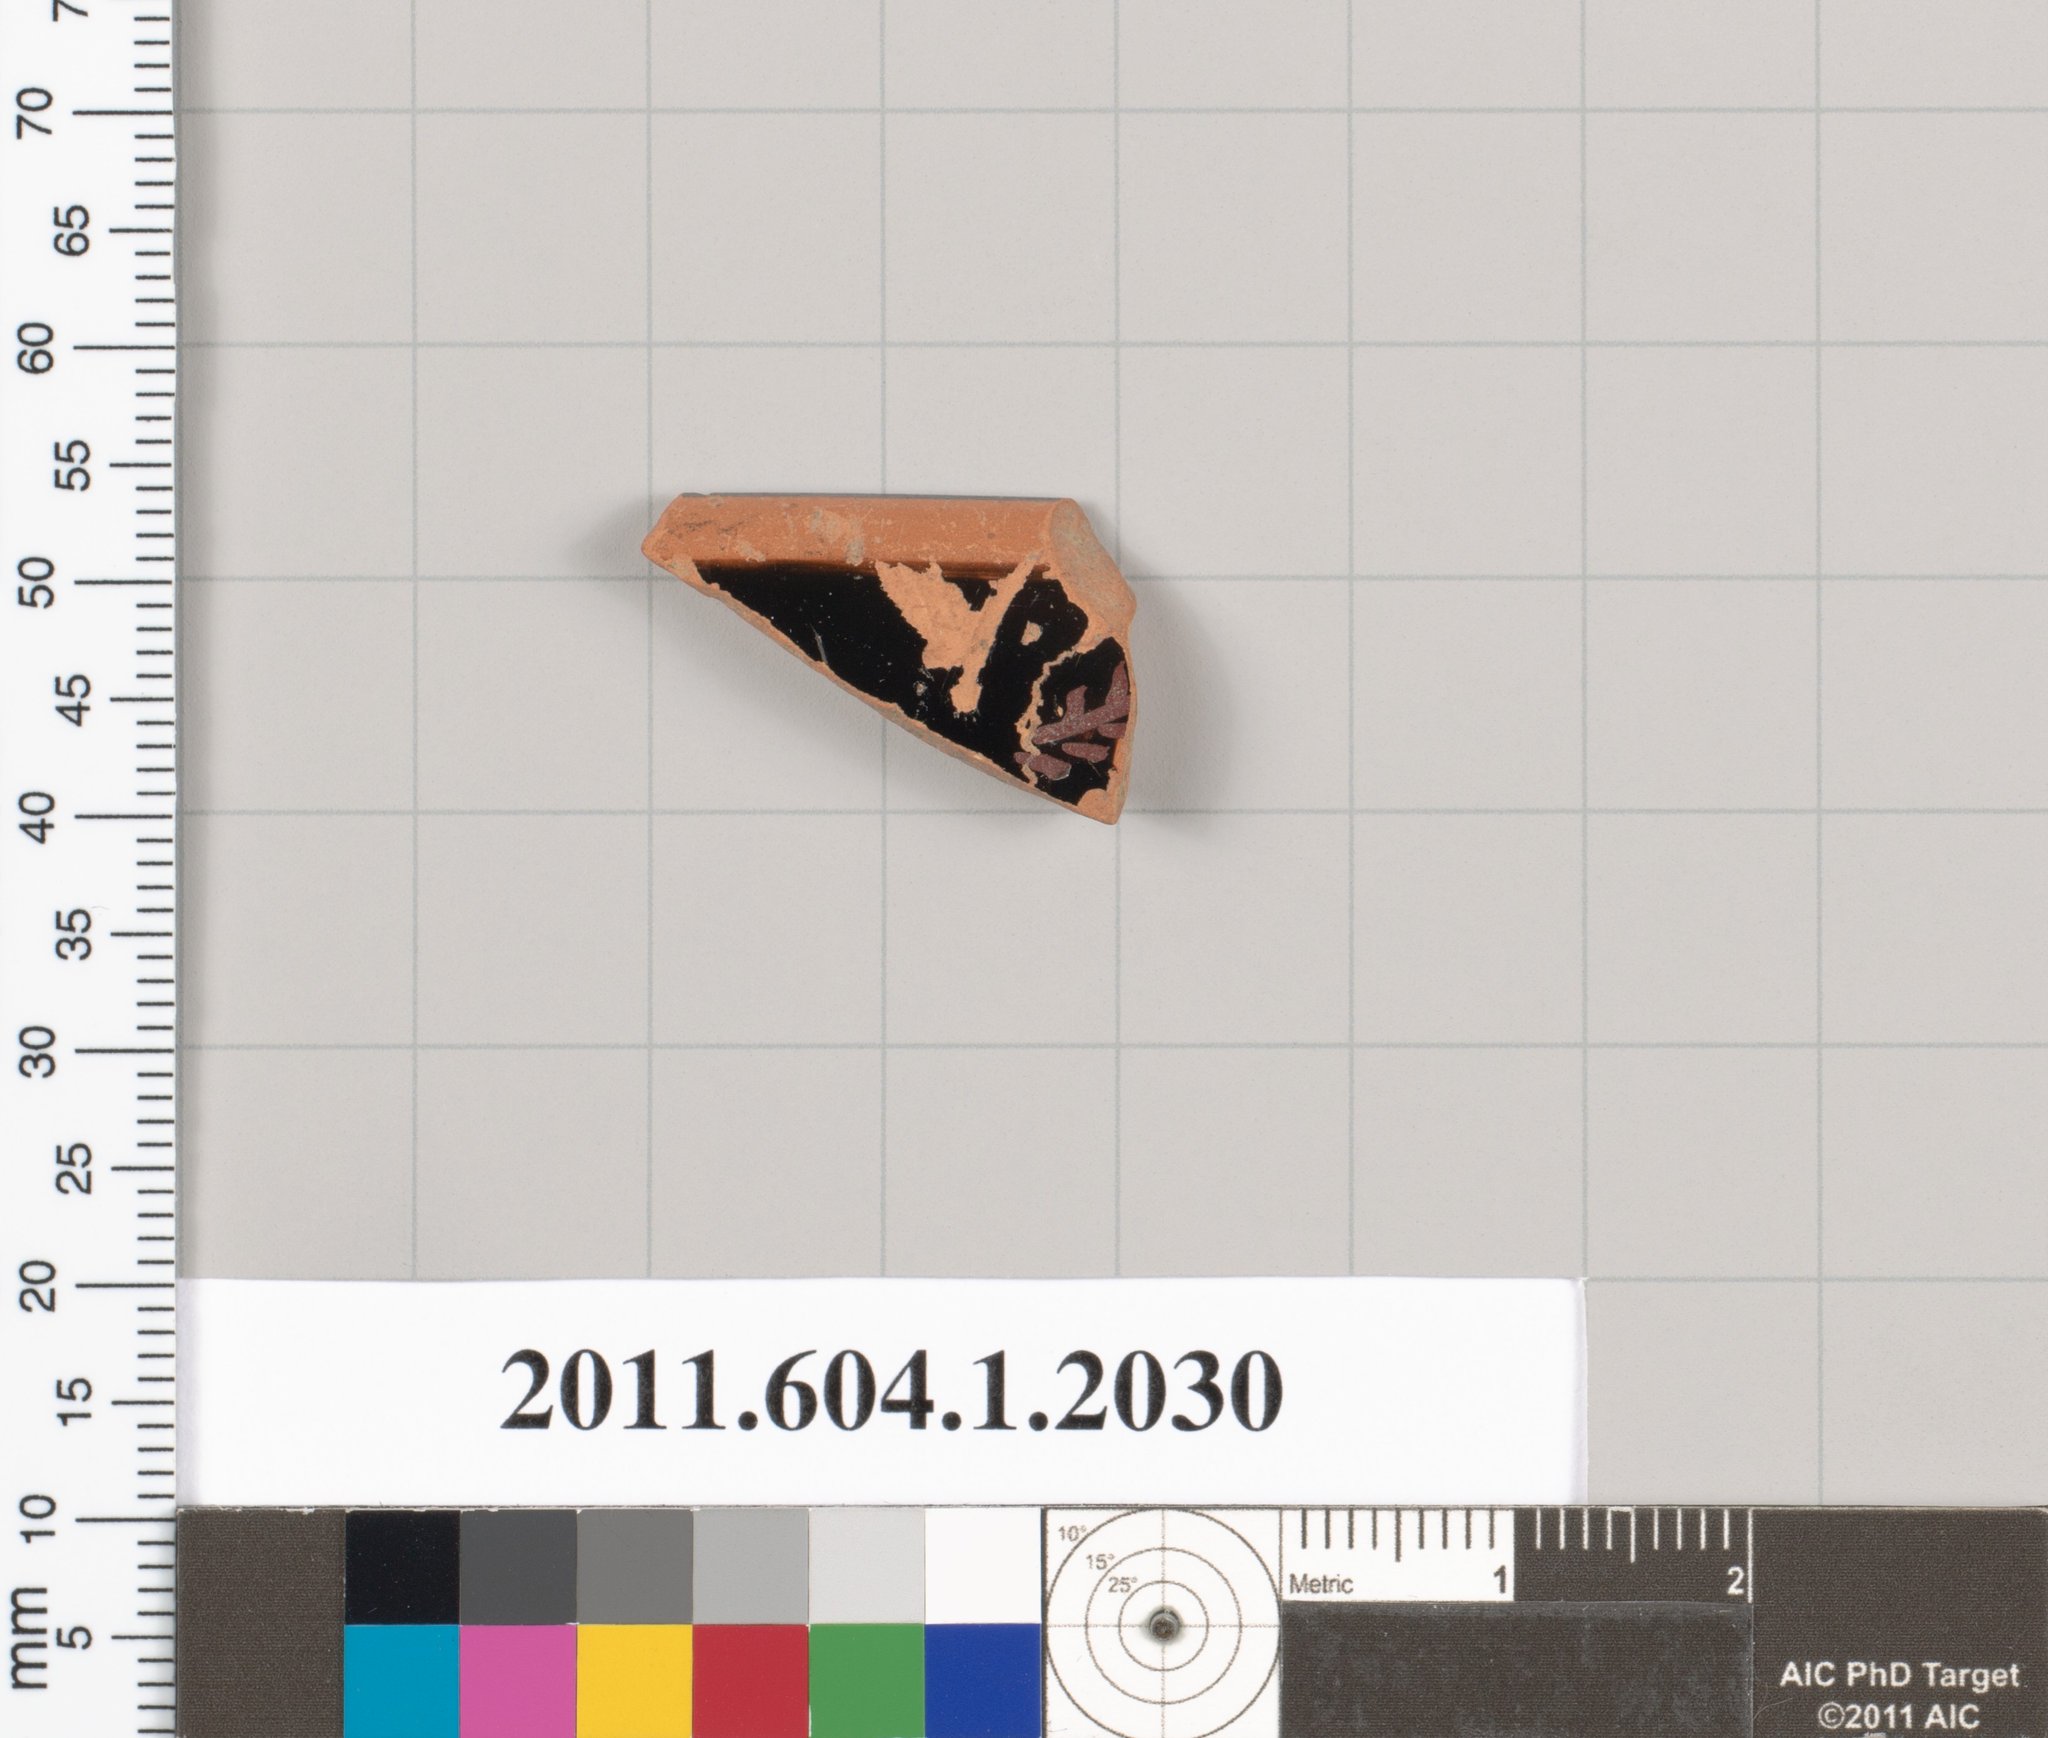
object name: kylix fragment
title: Terracotta rim fragment of a kylix (drinking cup)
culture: greek, attic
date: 534-468 BCE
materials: terracotta